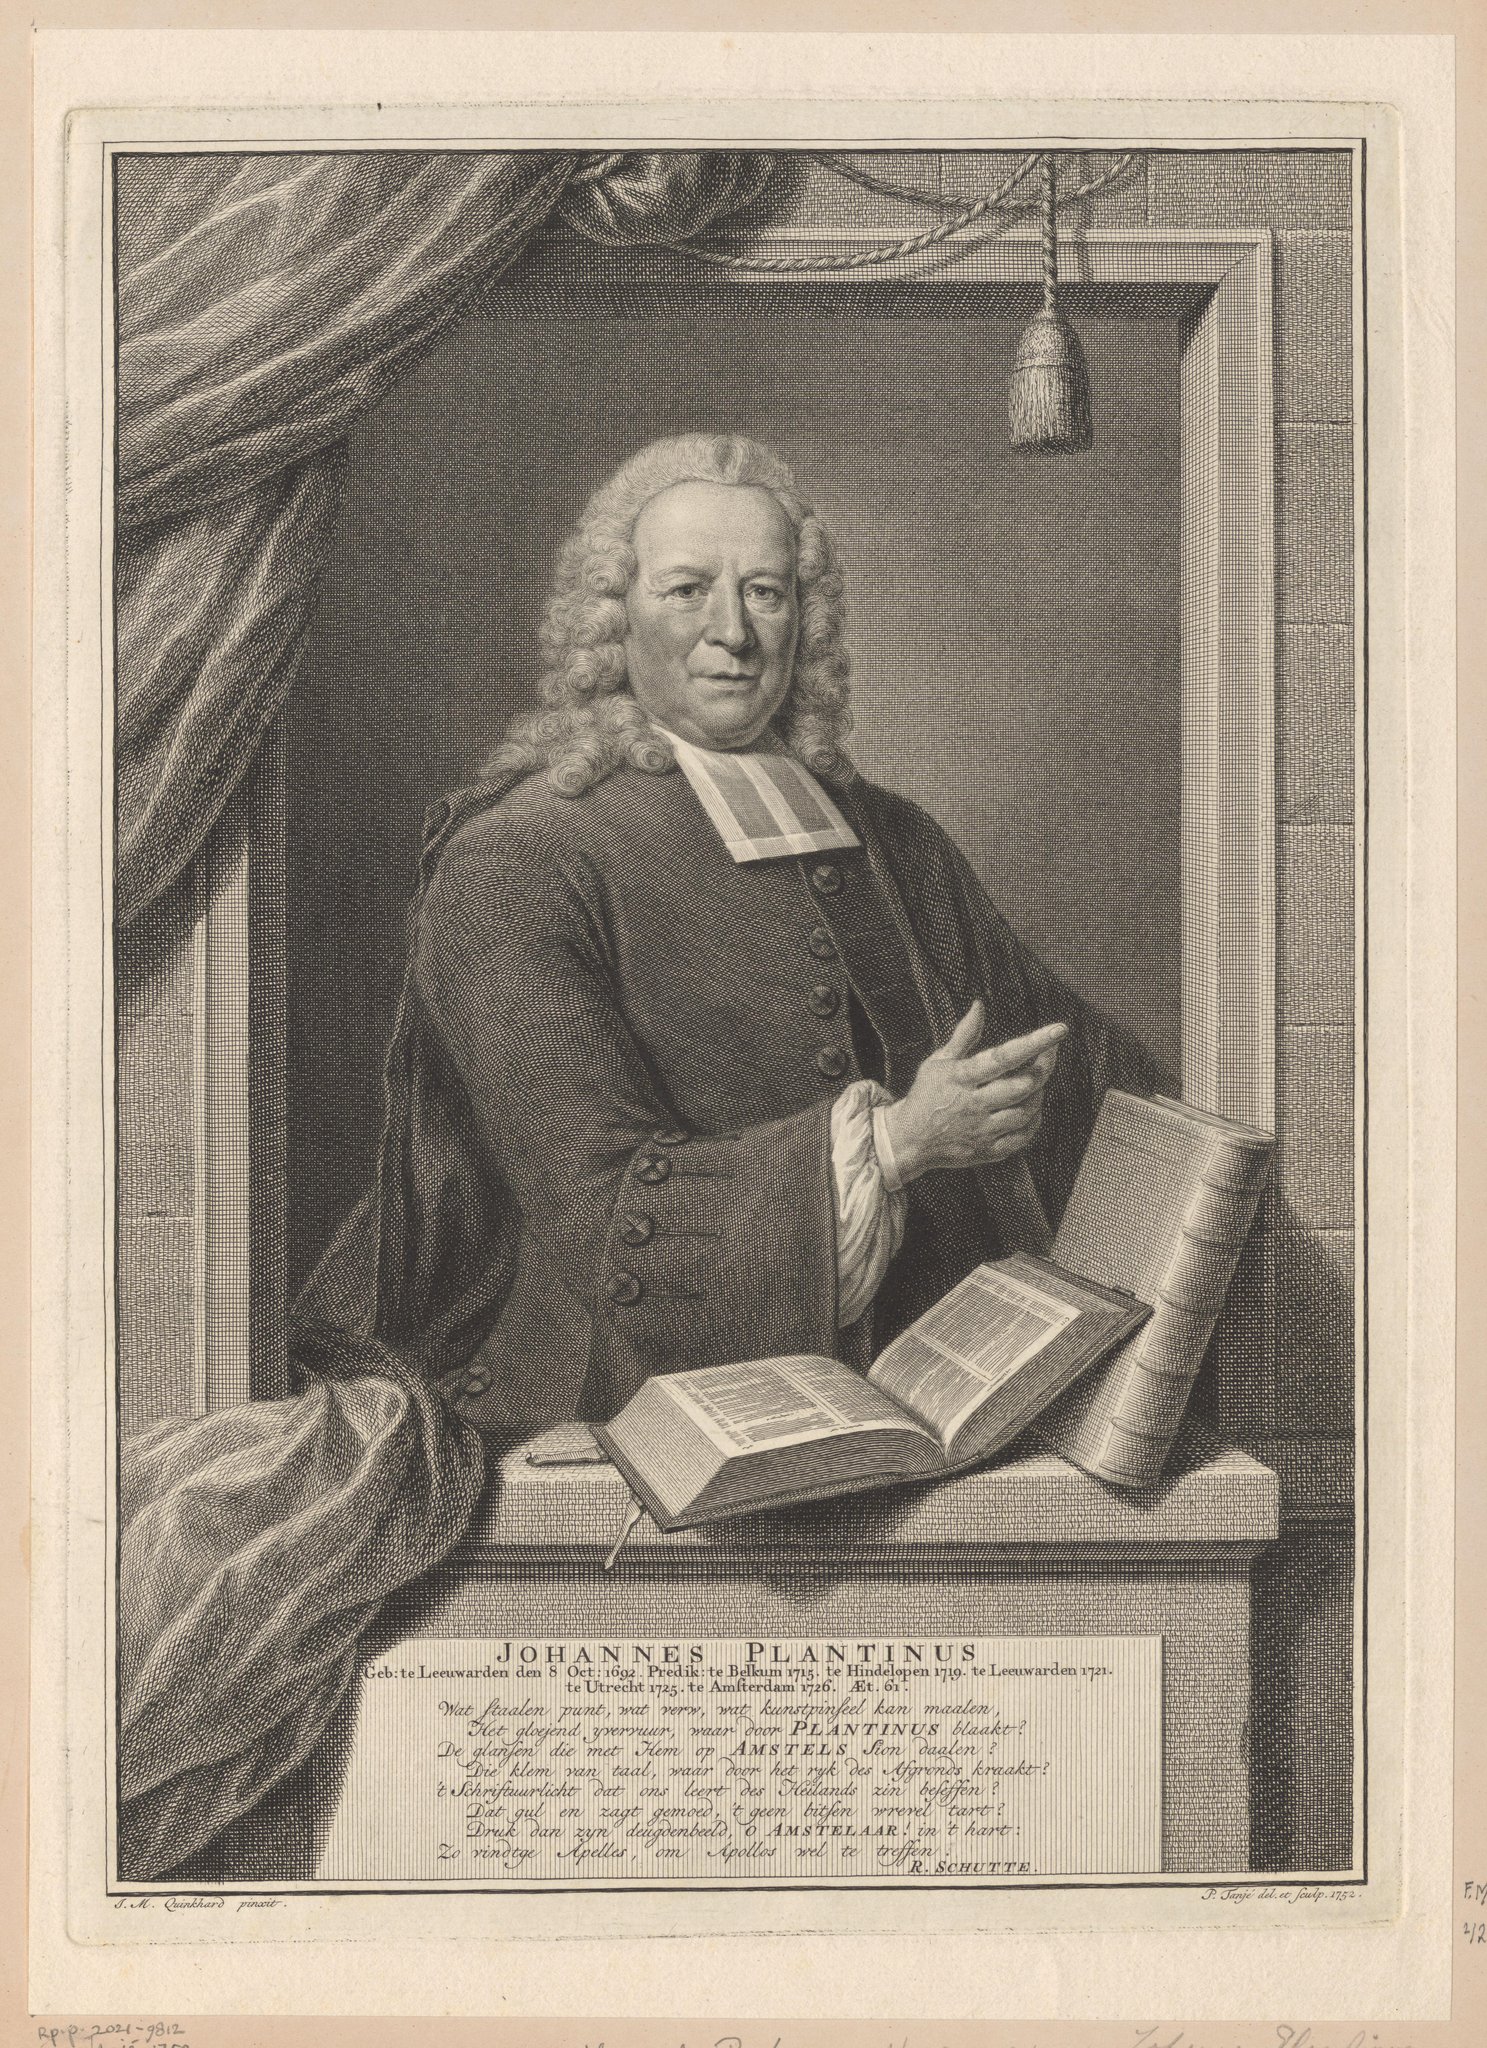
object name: print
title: Portret van Johannes Plantinus op 61-jarige leeftijd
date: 1752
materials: paper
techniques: engraving, etching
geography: amsterdam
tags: amsterdam, adult man, historical persons, the bible as a book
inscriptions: date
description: Onderaan een achtregelig vers in het Nederlands.